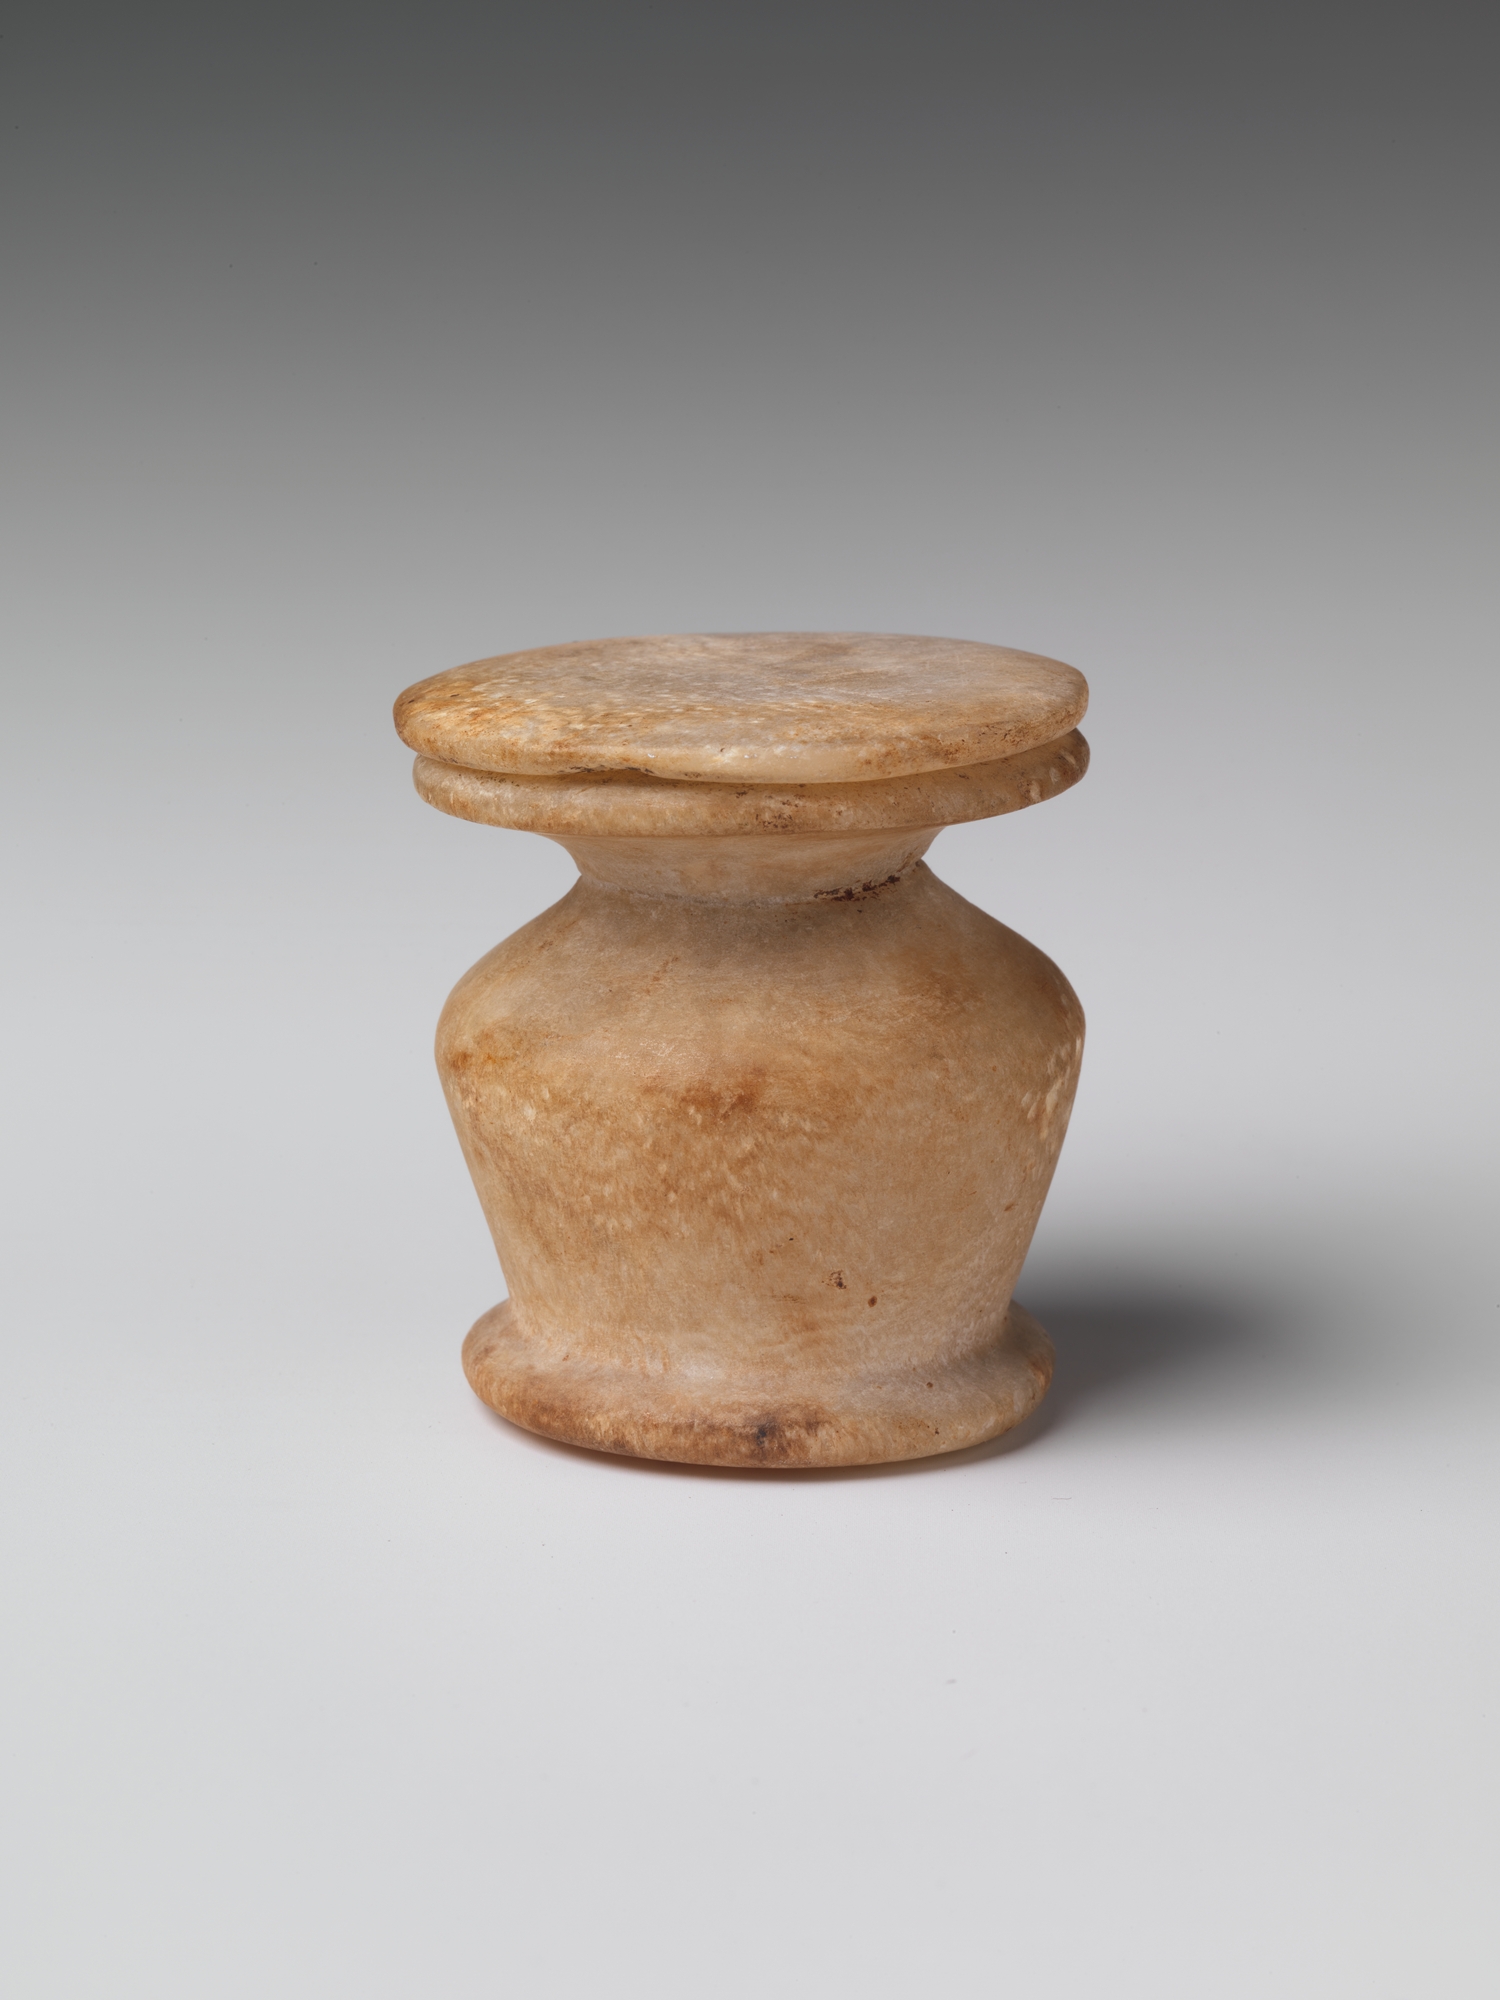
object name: kohl jar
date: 1635-1458 BCE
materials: stone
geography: egypt